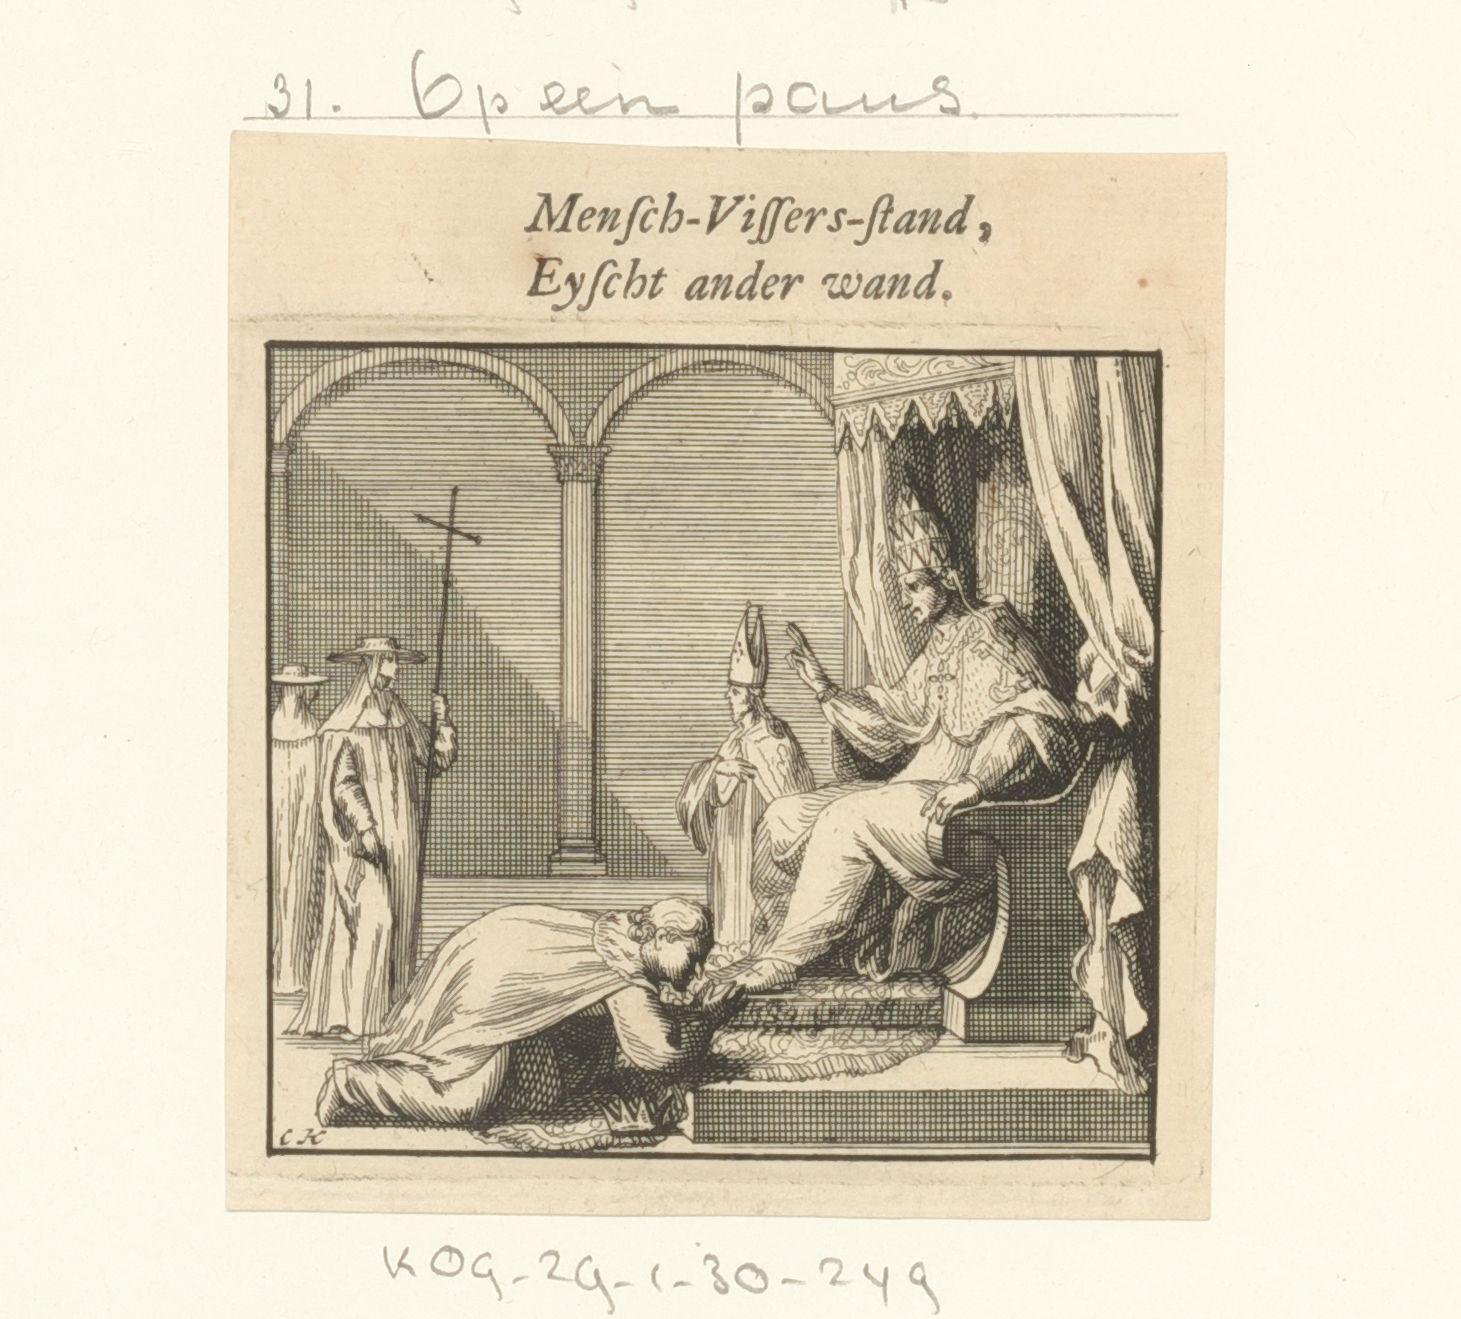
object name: print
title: Man kust de voeten van een paus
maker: cornelis huyberts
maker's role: print maker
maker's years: 1669-1709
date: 1725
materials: paper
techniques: etching, letterpress printing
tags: kissing the pope's feet, pope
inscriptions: stamp, collector's mark: Lugt 1641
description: Prent uit: Graauwhart, Hendrik. Voorbeeldelyke zeede-lessen, genoomen uyt den eersten toestand des werelds (...). Amsterdam: Johannes Ratelband, 1725. Prent ook gebruikt voor eerdere en (1709) latere uitgave (1756, 1761 en 1764).